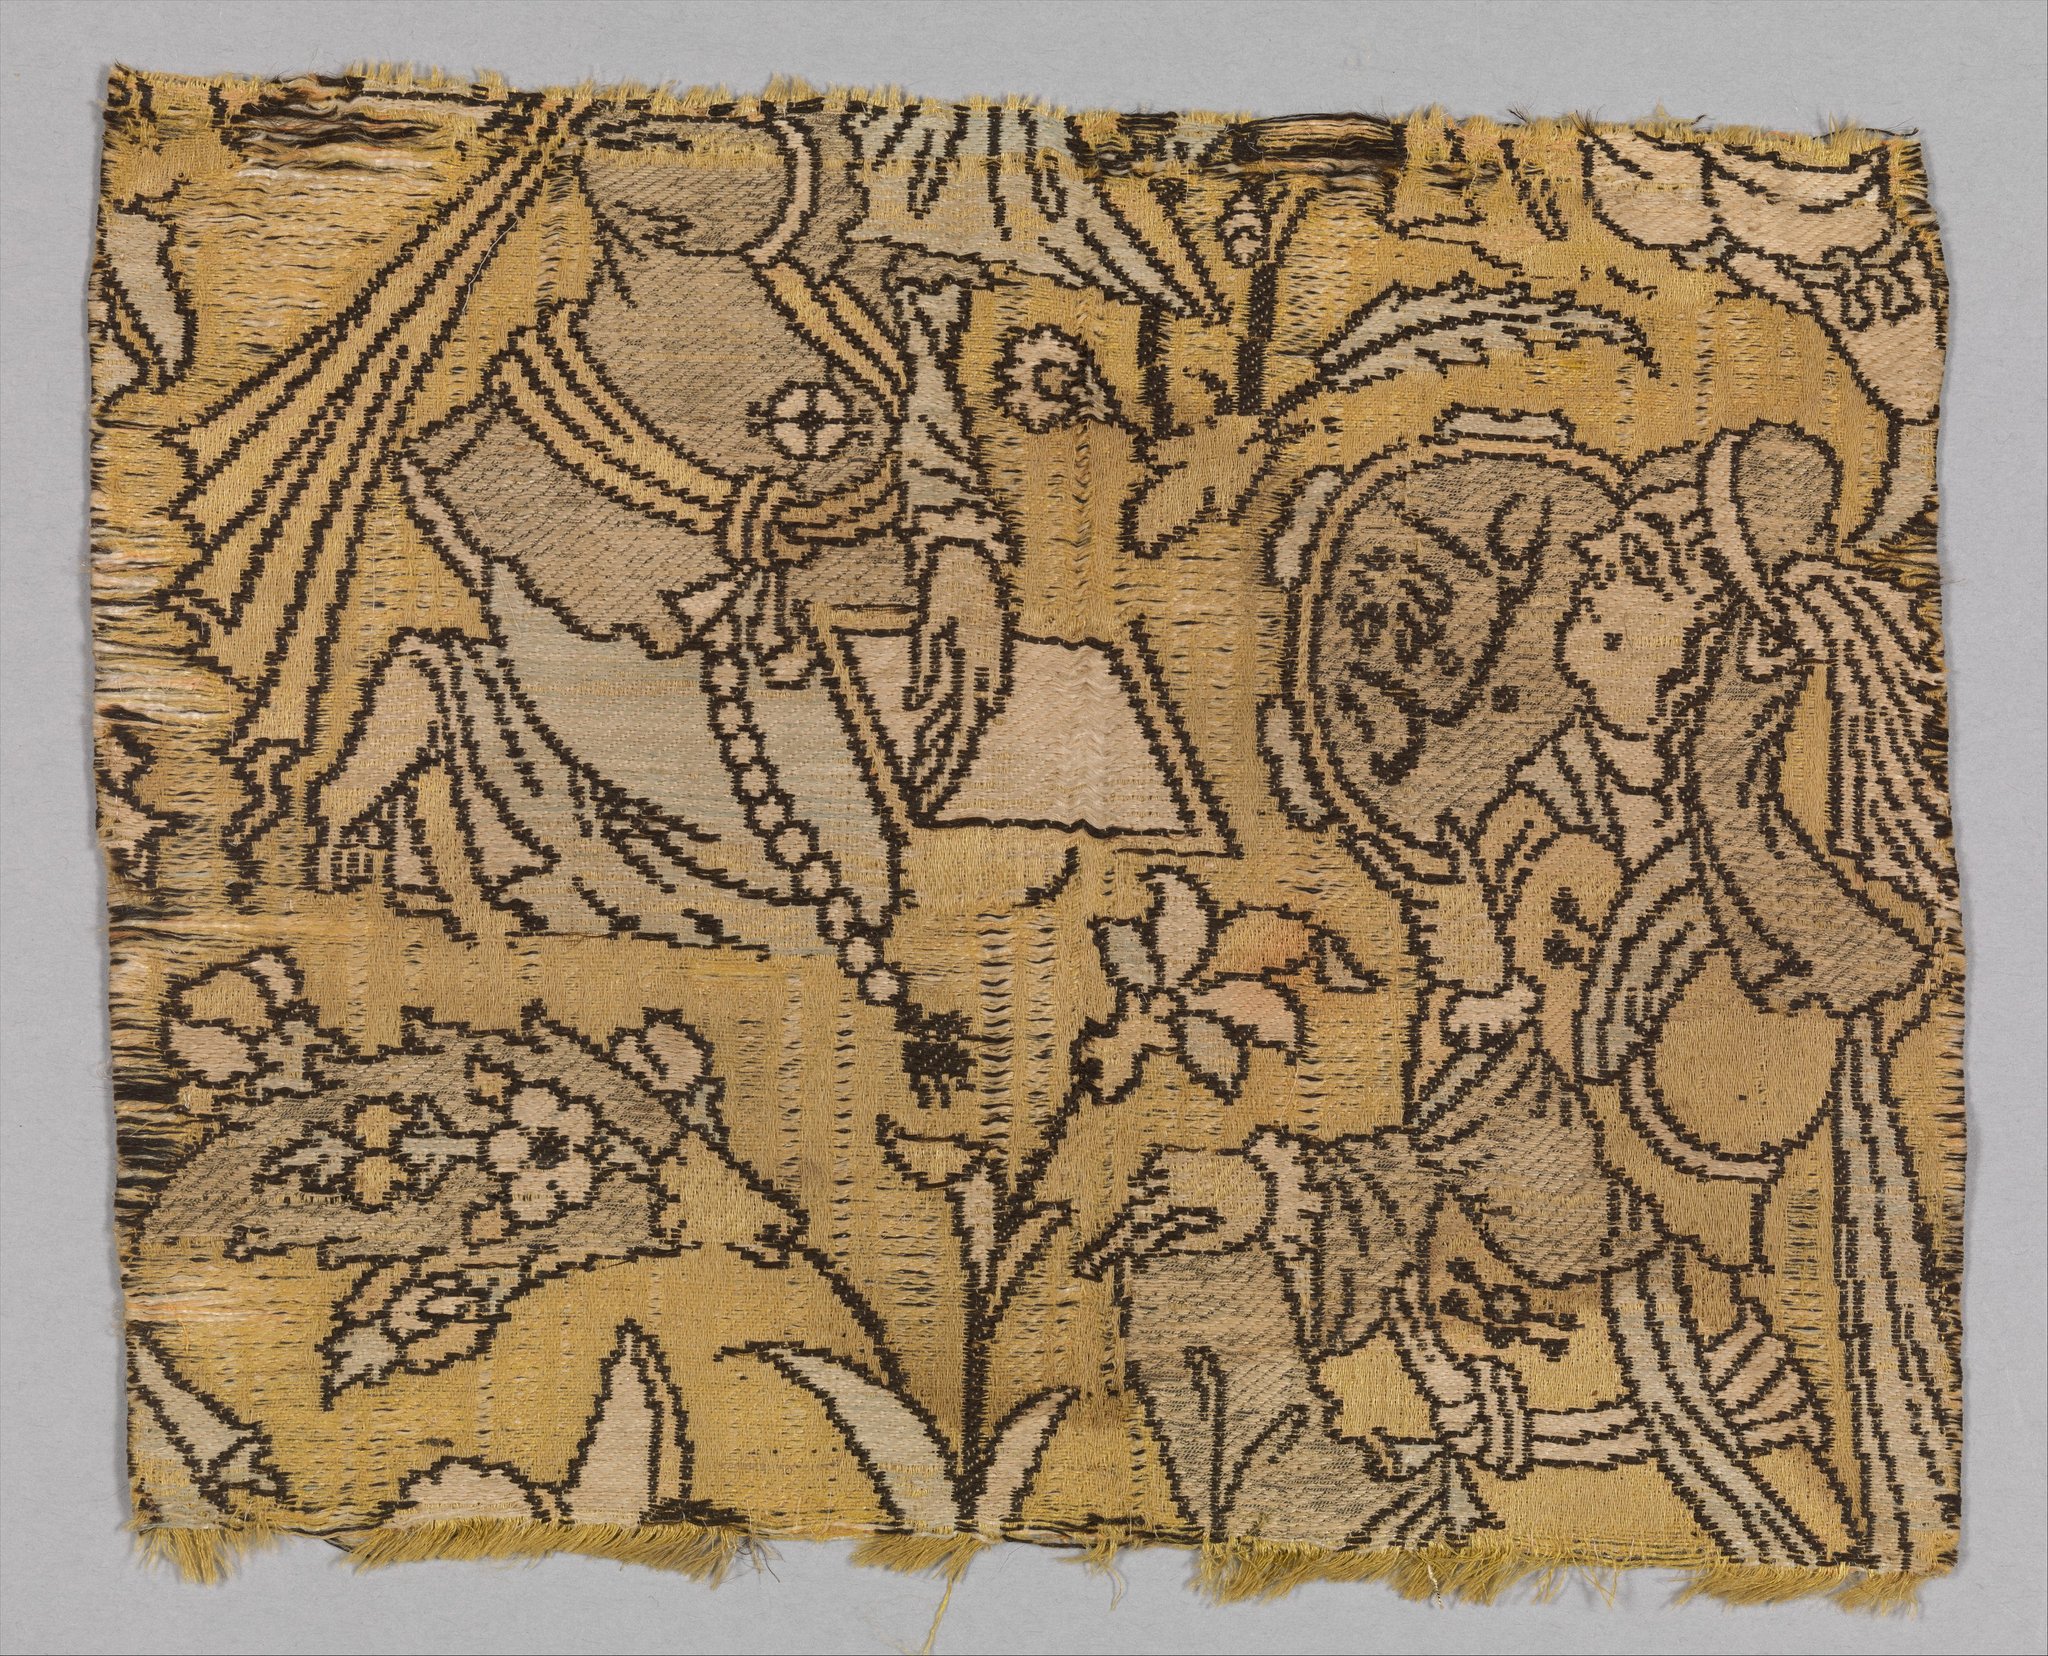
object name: textile fragment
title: Fragment with a Garden Scene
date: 1601-1633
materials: metal thread, silk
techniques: lampas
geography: iran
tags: musical instruments,gardens,plants,musicians